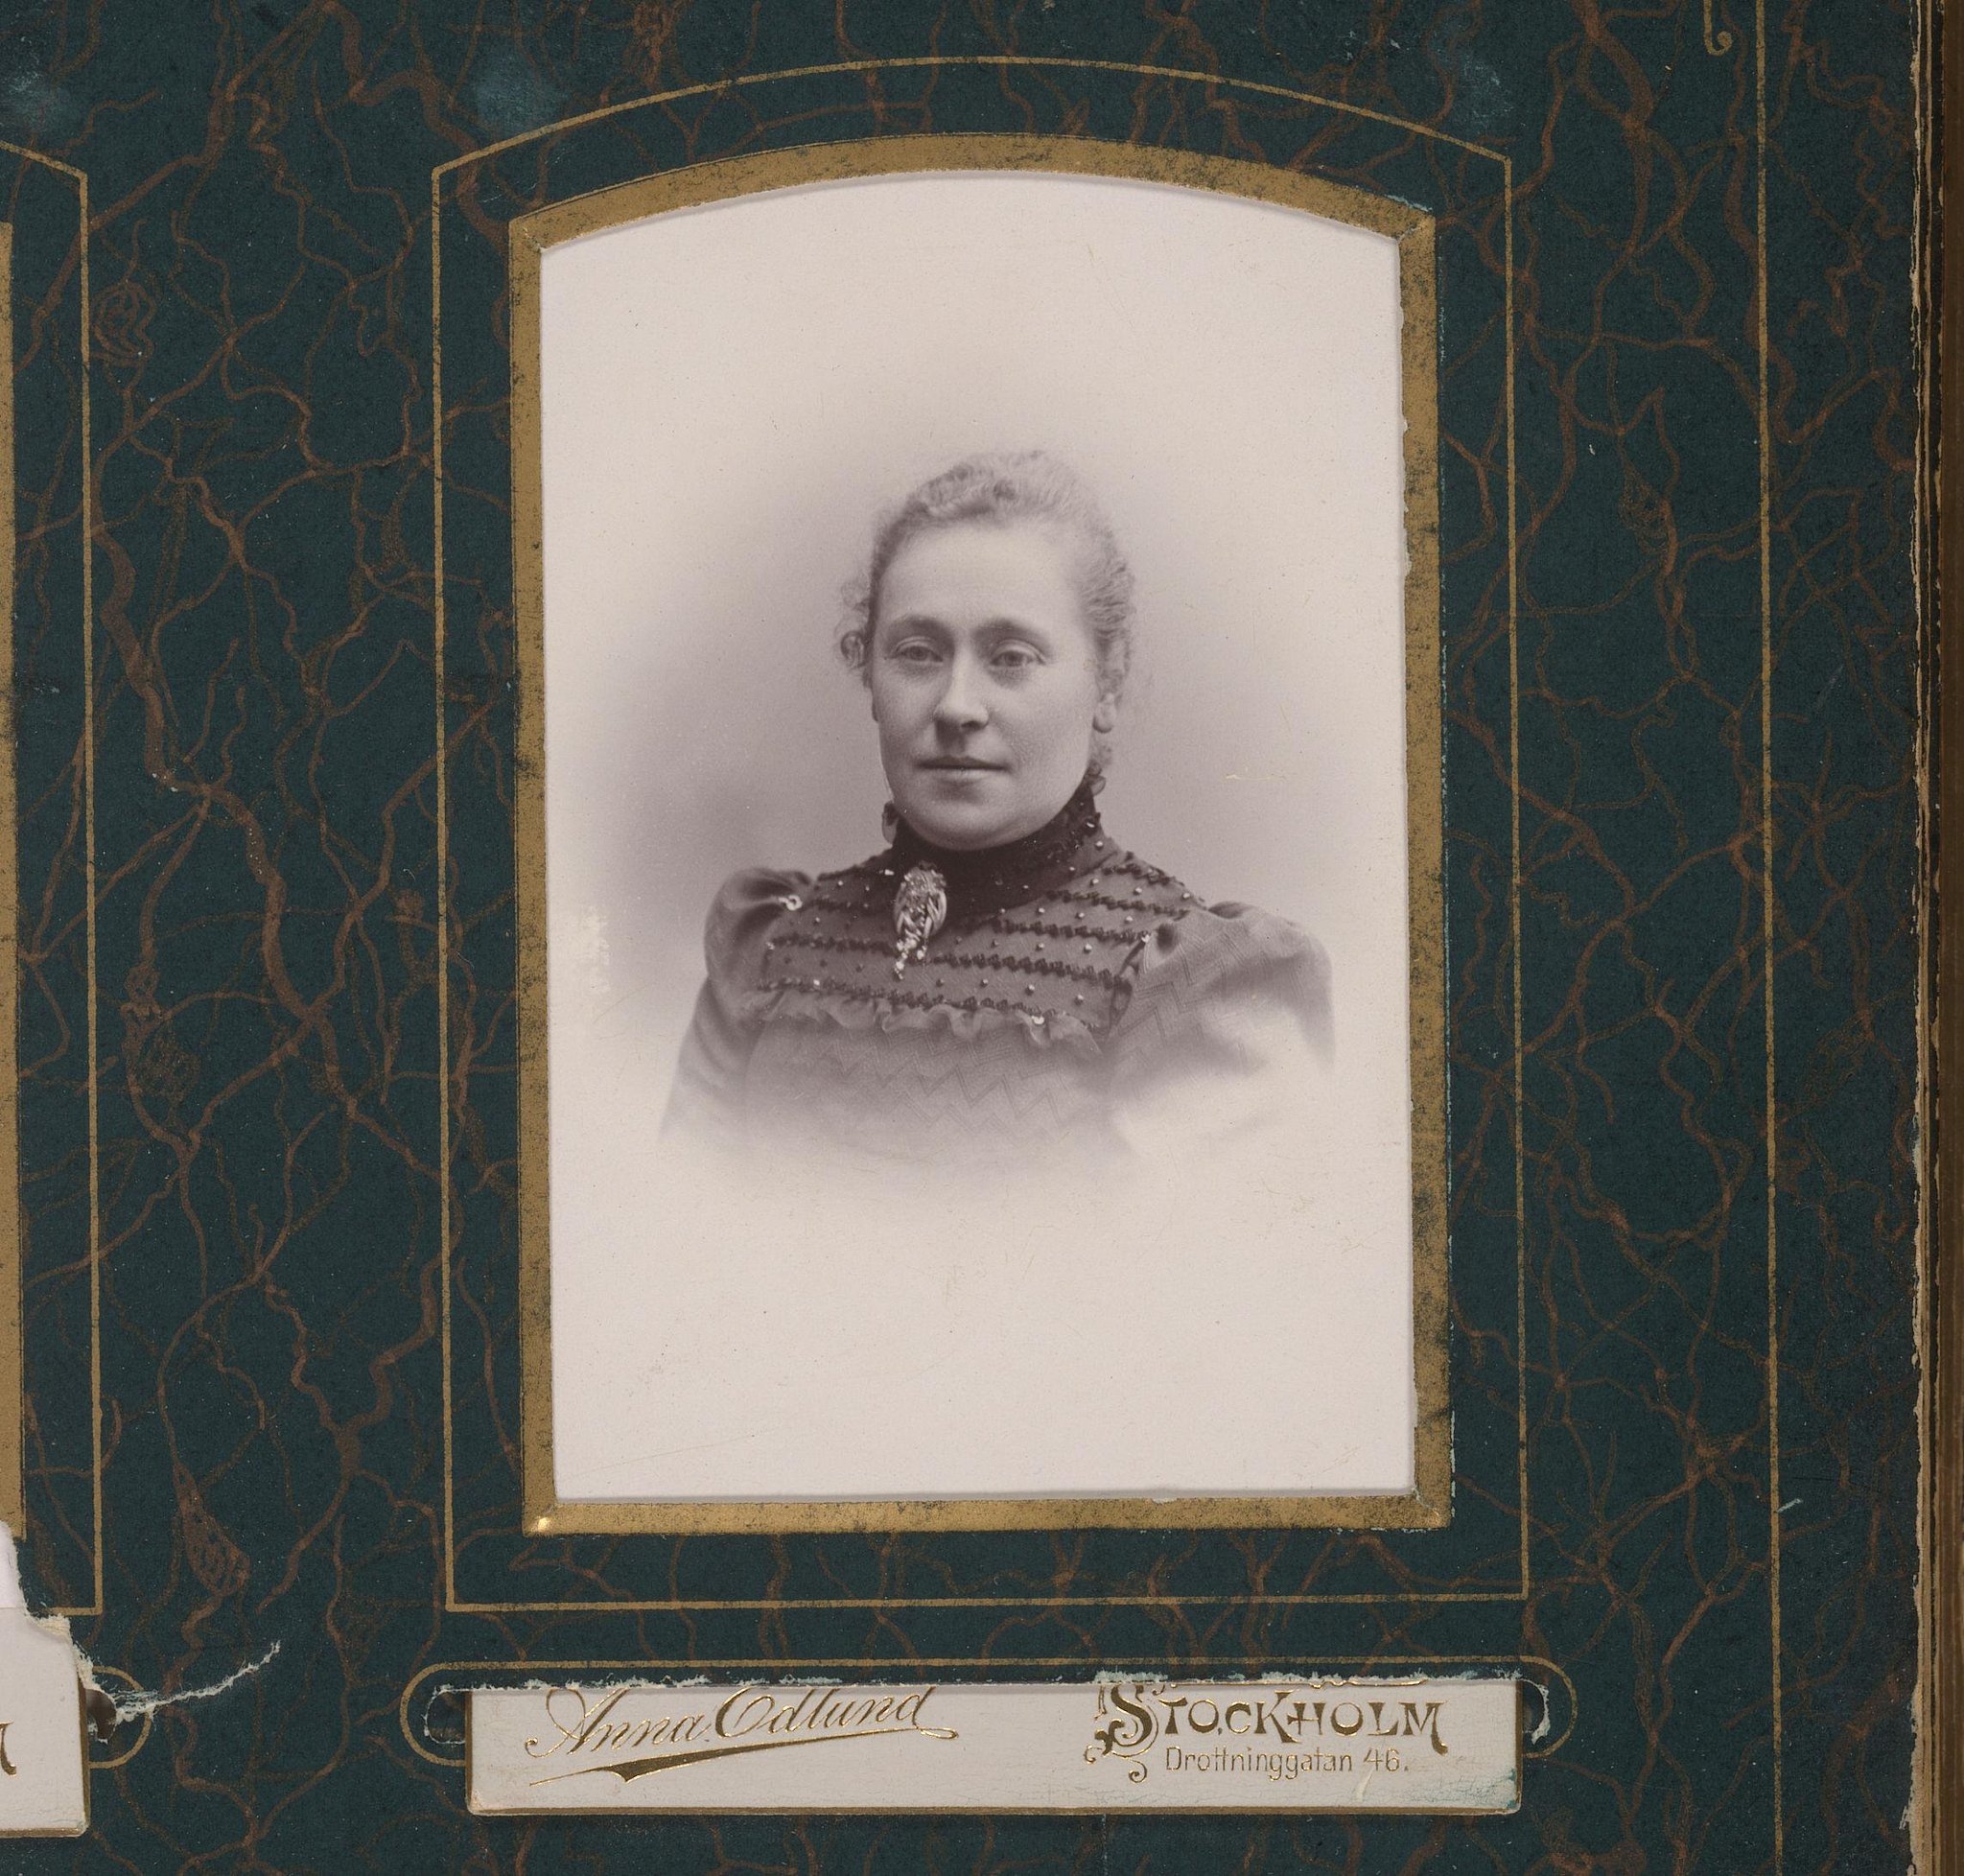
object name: photograph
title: Portret van een vrouw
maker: anna edlund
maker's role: fotograaf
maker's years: 1852-1932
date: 1897-1920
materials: cardboard, photographic support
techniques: collodion silver print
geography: stockholm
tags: historical persons - bb - woman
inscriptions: inscription: ‘SILFVER MEDALJ/ STOCKHOLM 1897./ Anna Edlund/ Stockholm/ Drottninggatan/ 46./ TELEFON No 10802./ Plåten förvaras.’